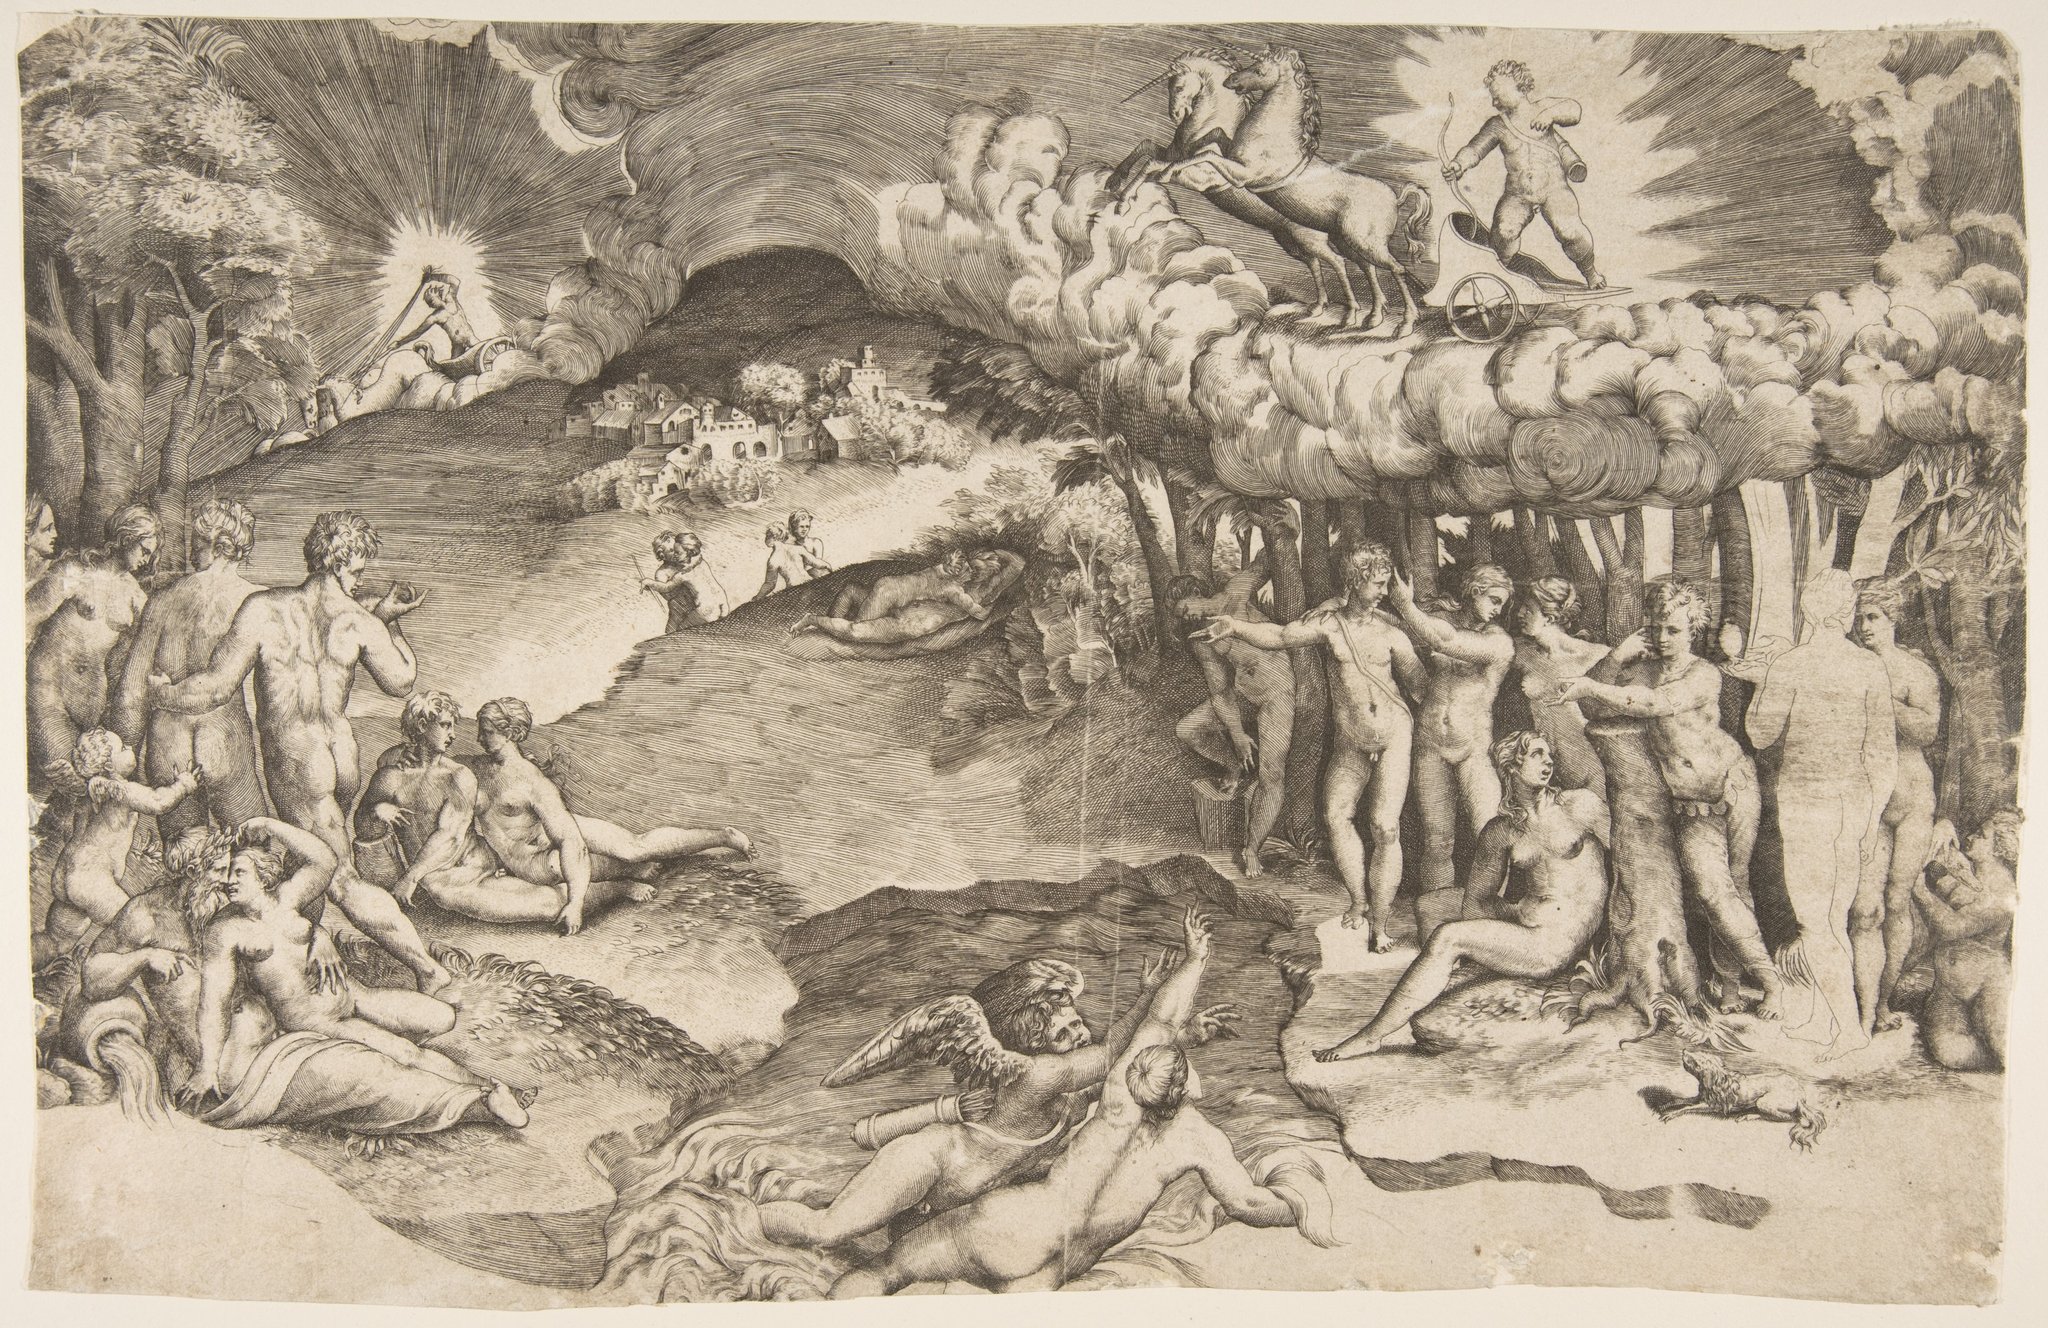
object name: print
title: The triumph of love, cupid riding a chariot drawn by unicorn is in the upper right, naked figures fill the composition; a proof impression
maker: giulio bonasone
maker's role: artist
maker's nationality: italian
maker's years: 1510-1576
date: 1545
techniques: engraving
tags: male nudes,female nudes,cupid,unicorns,chariots